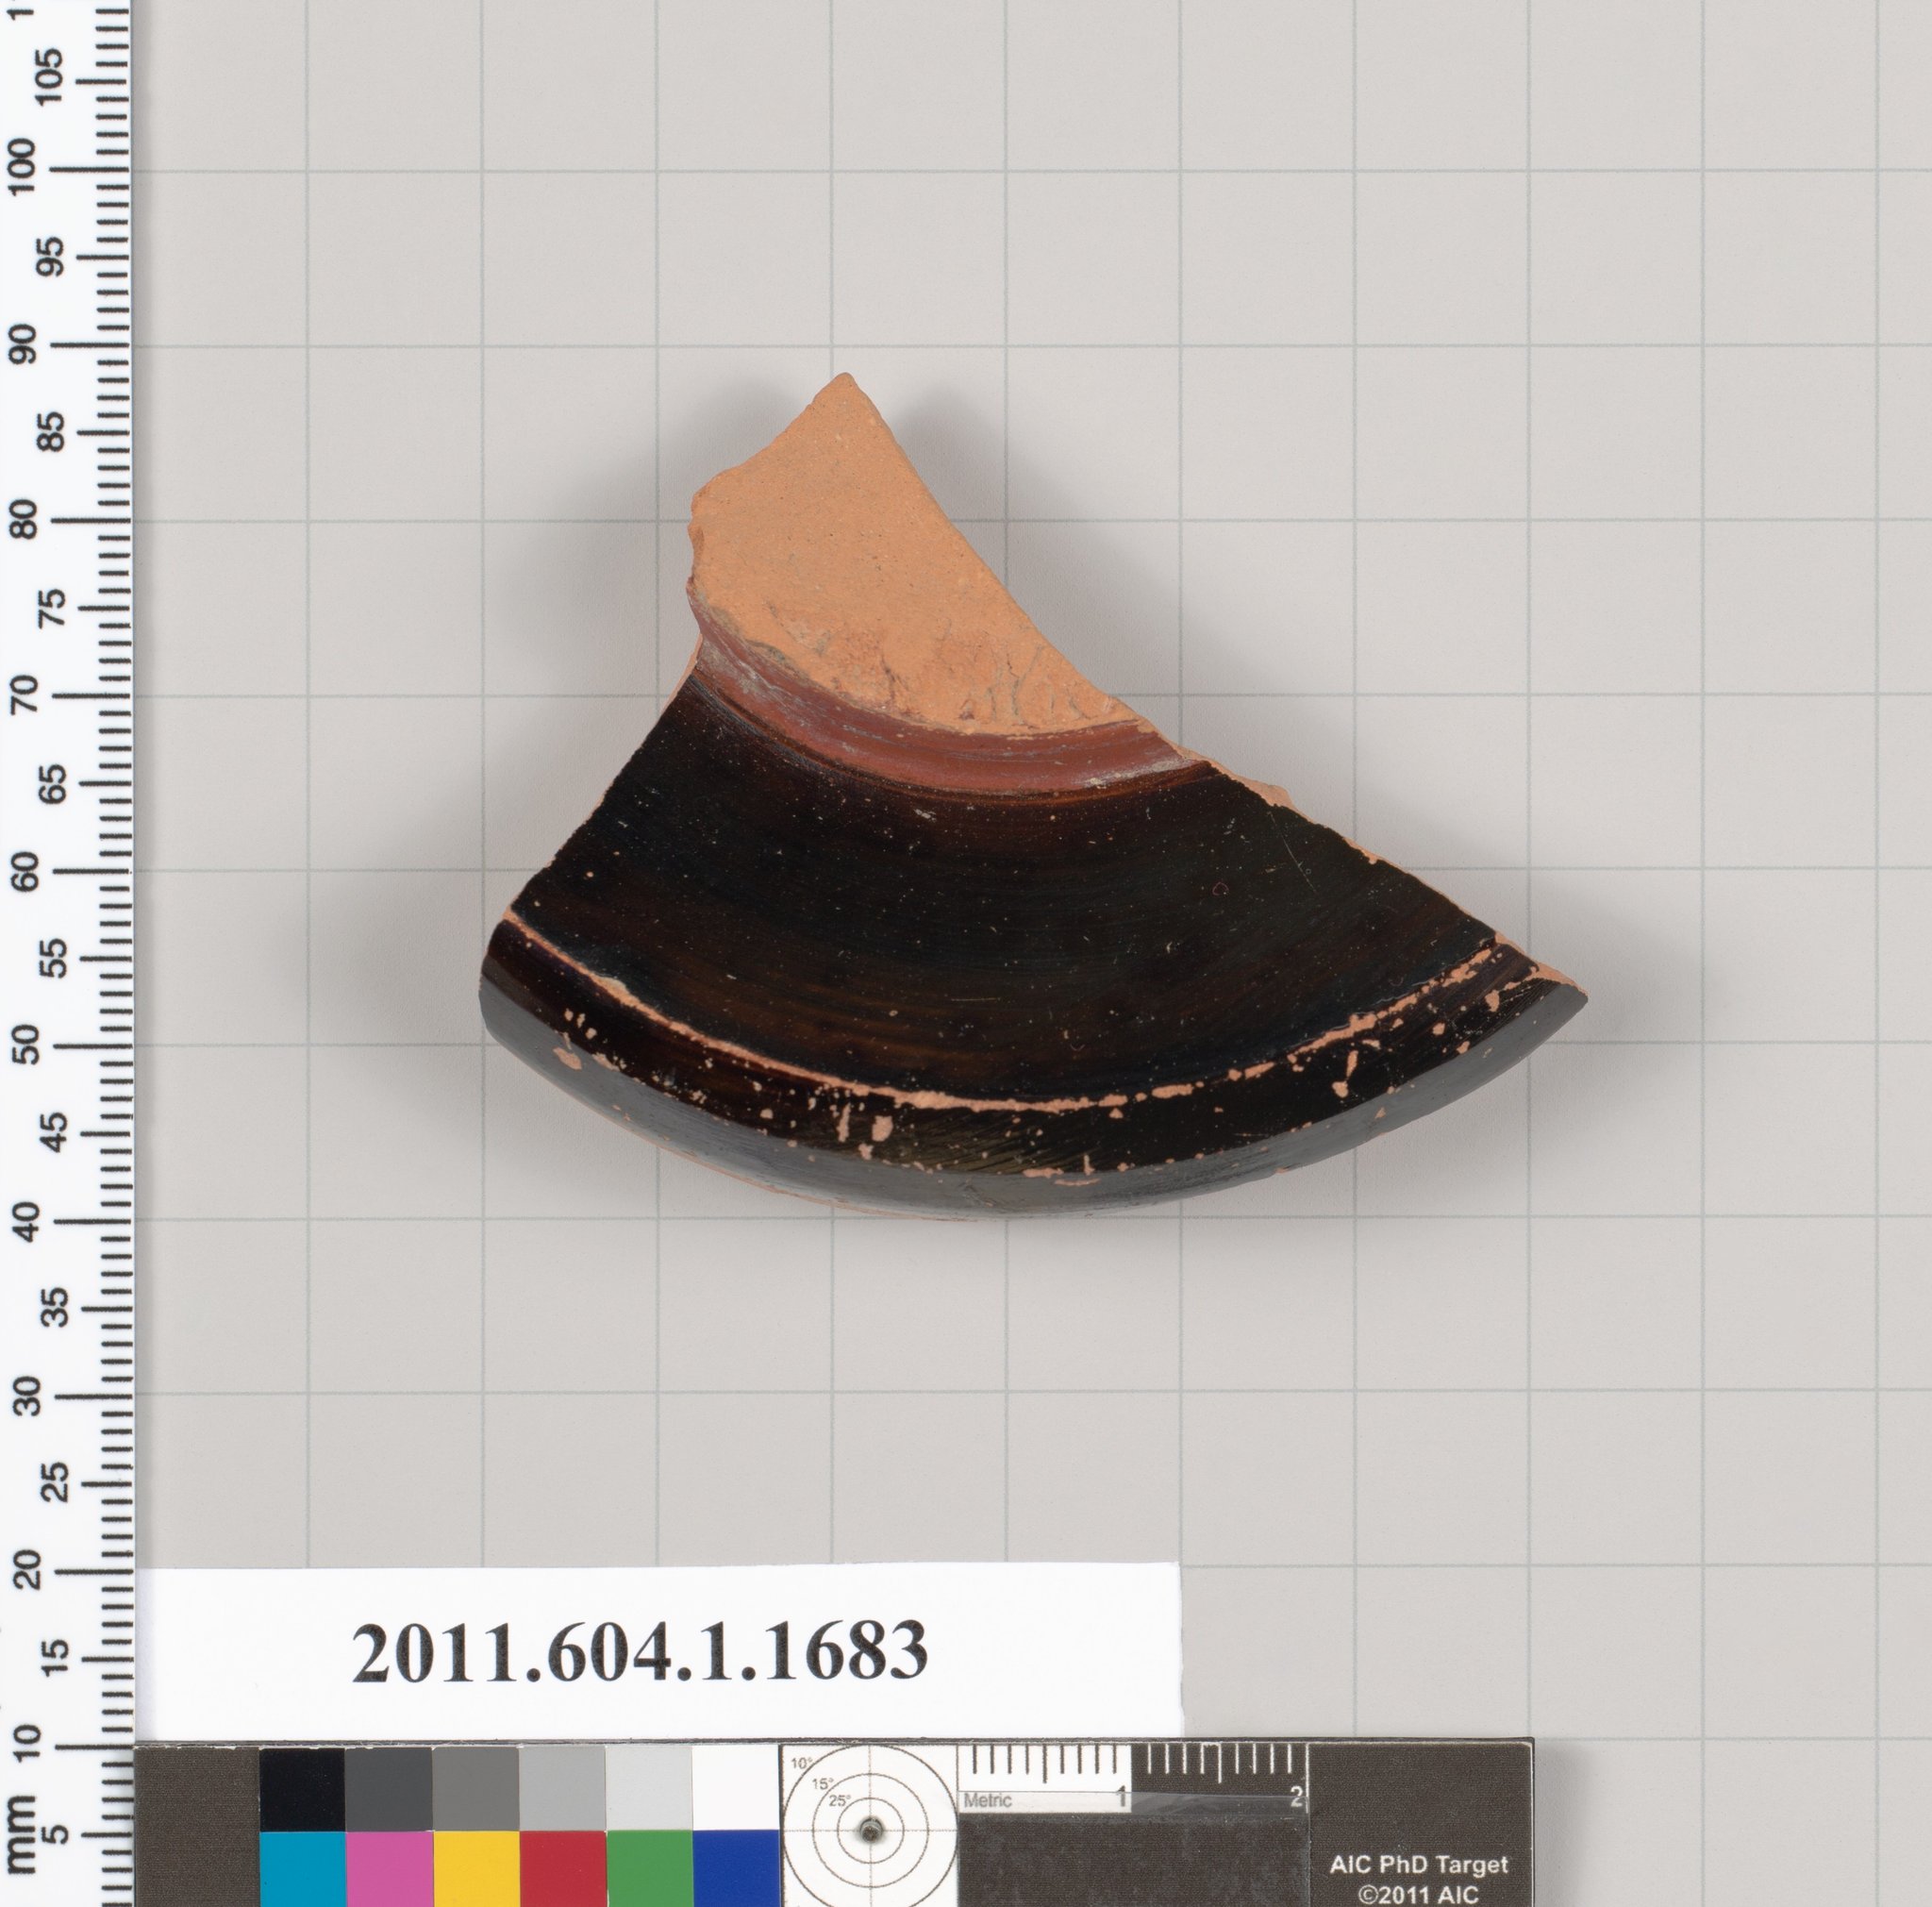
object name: kylix fragment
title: Terracotta fragment of a kylix? (drinking cup)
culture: greek, attic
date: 500-401 BCE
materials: terracotta